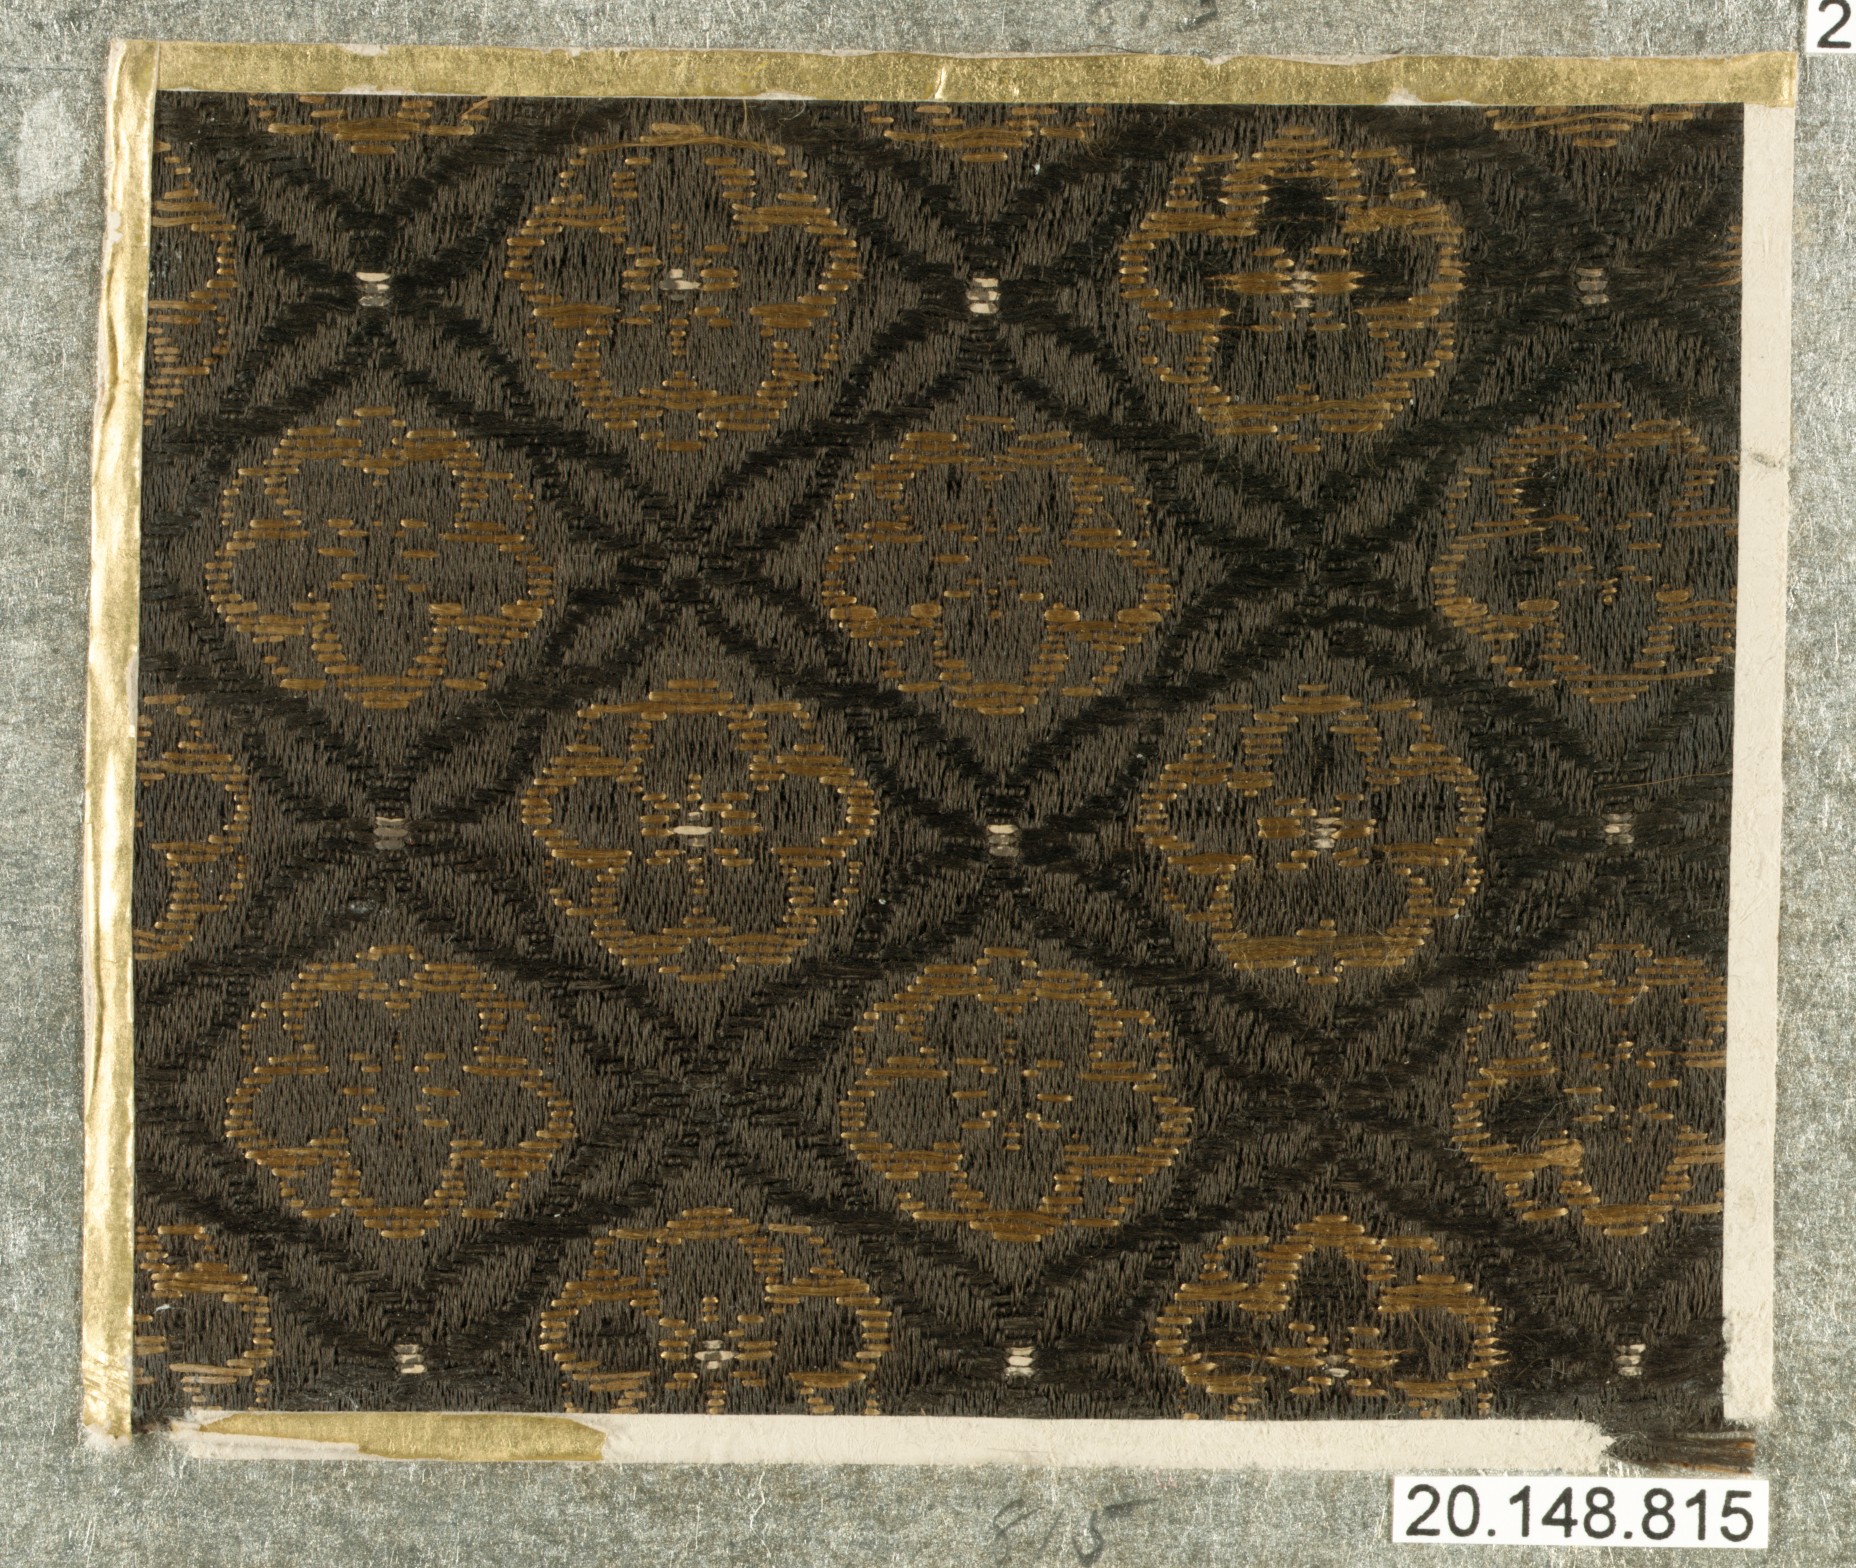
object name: piece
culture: japanese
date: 1701-1800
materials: silk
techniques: compound weave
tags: flowers